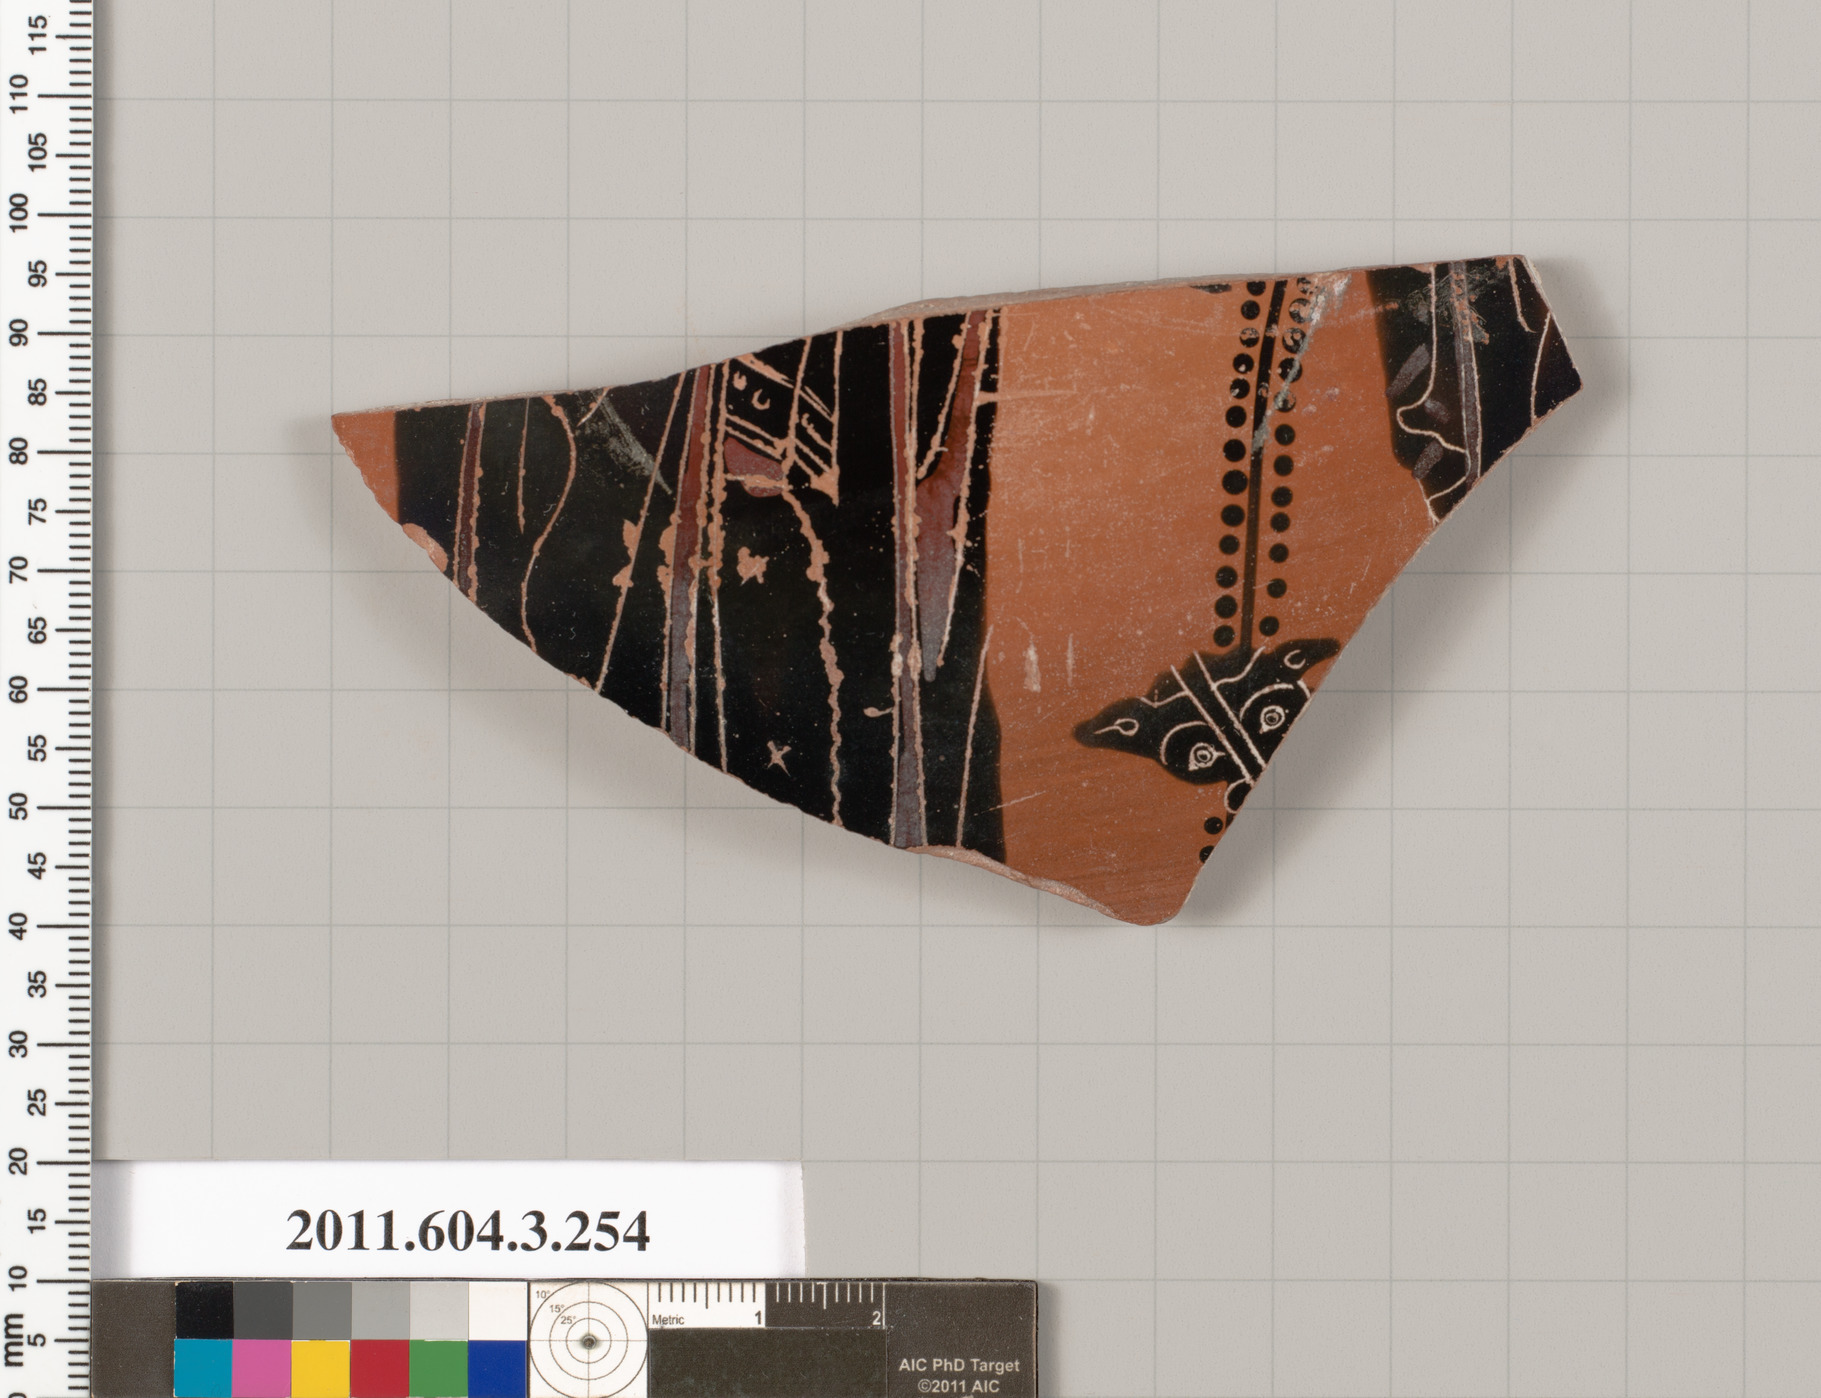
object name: neck amphora fragment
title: Terracotta fragment of a neck-amphora (jar)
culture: greek, attic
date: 530-520 BCE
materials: terracotta